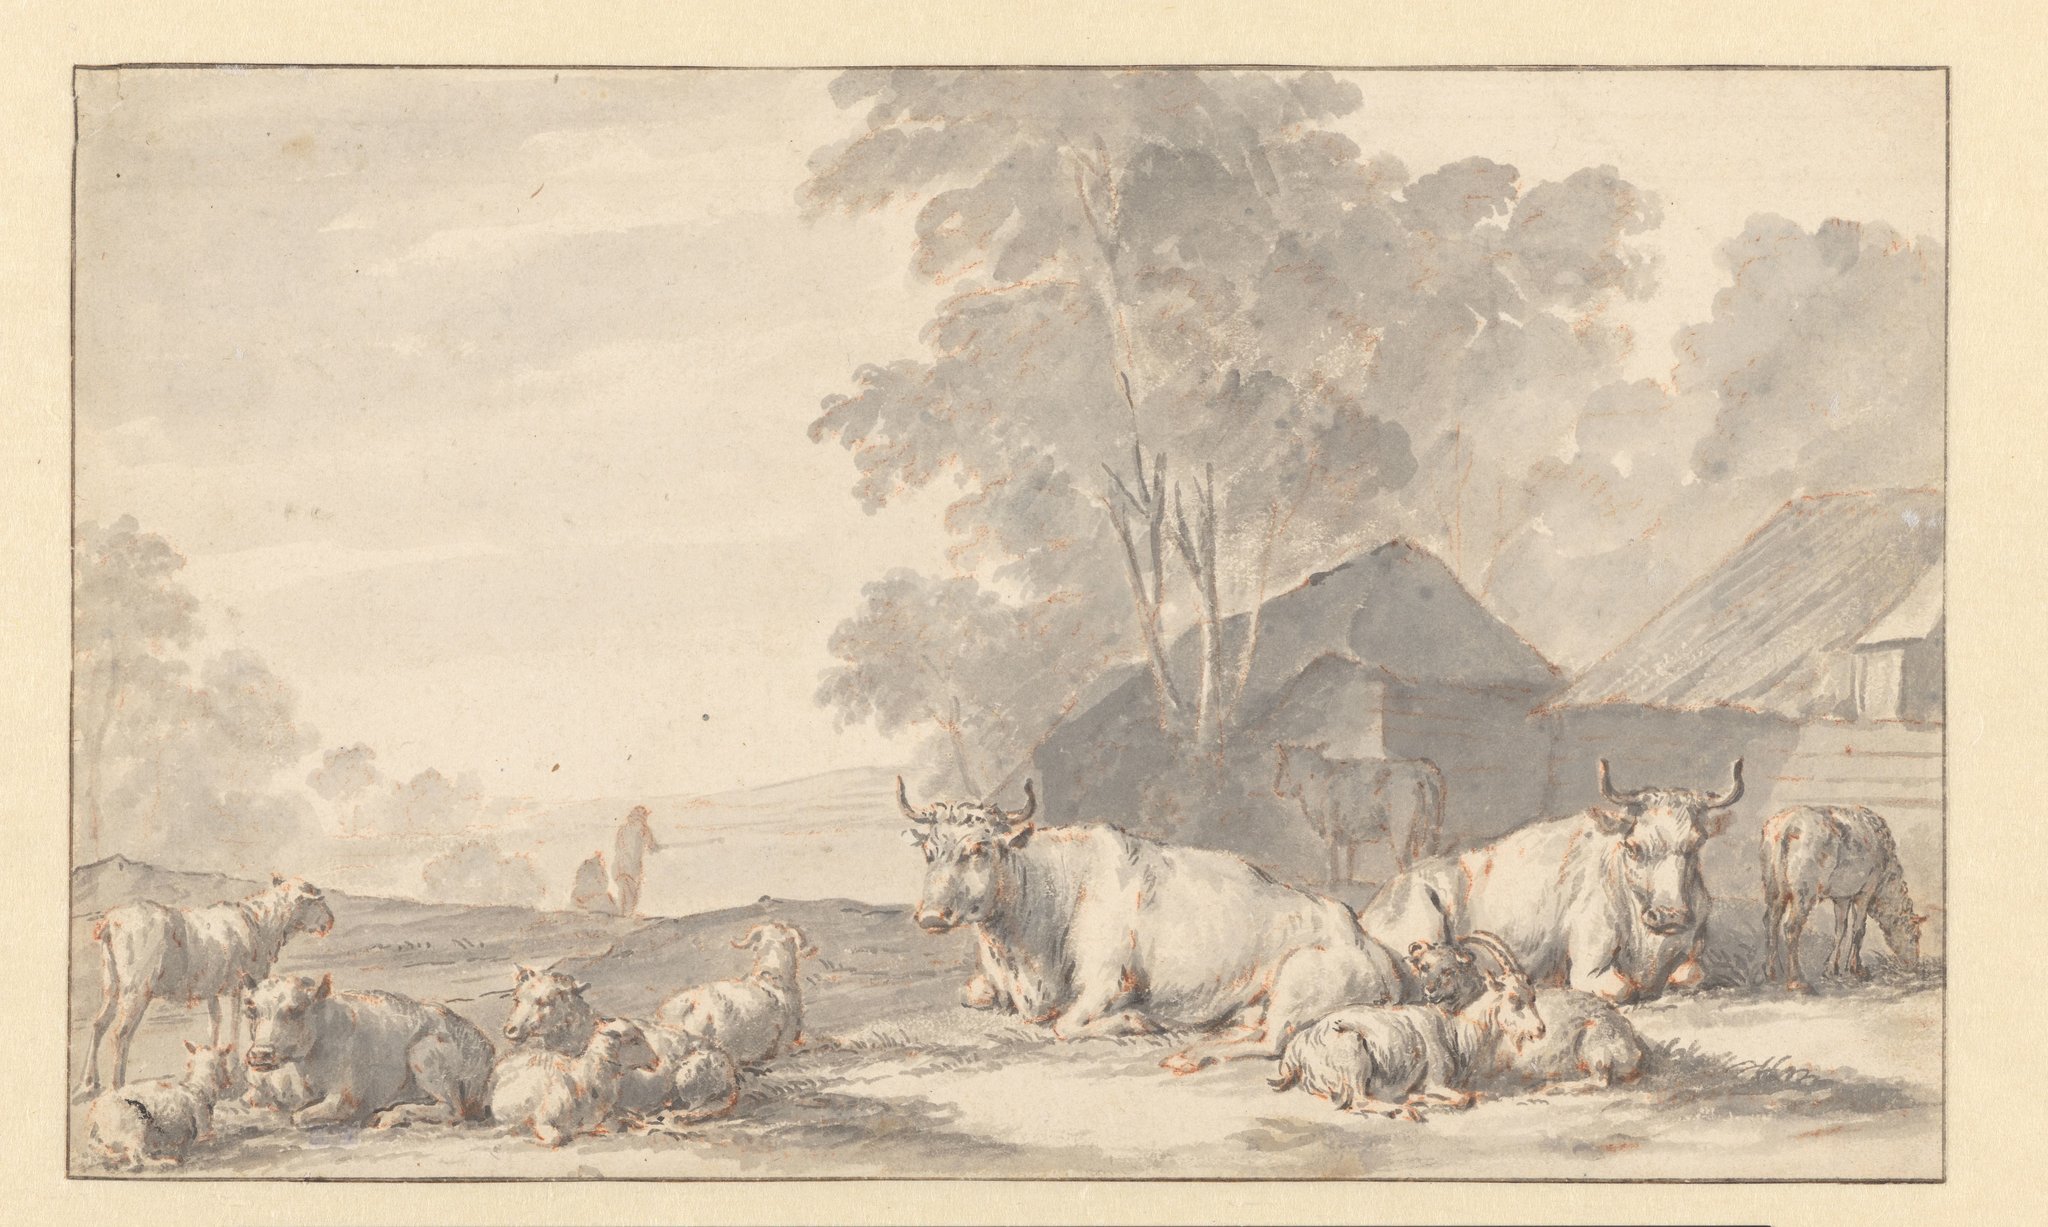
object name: drawing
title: Landschap met vee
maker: albert jansz klomp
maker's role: draughtsman, painter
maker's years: 1618-1688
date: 1628-1688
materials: chalk, paper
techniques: brush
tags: cattle, farm (building)